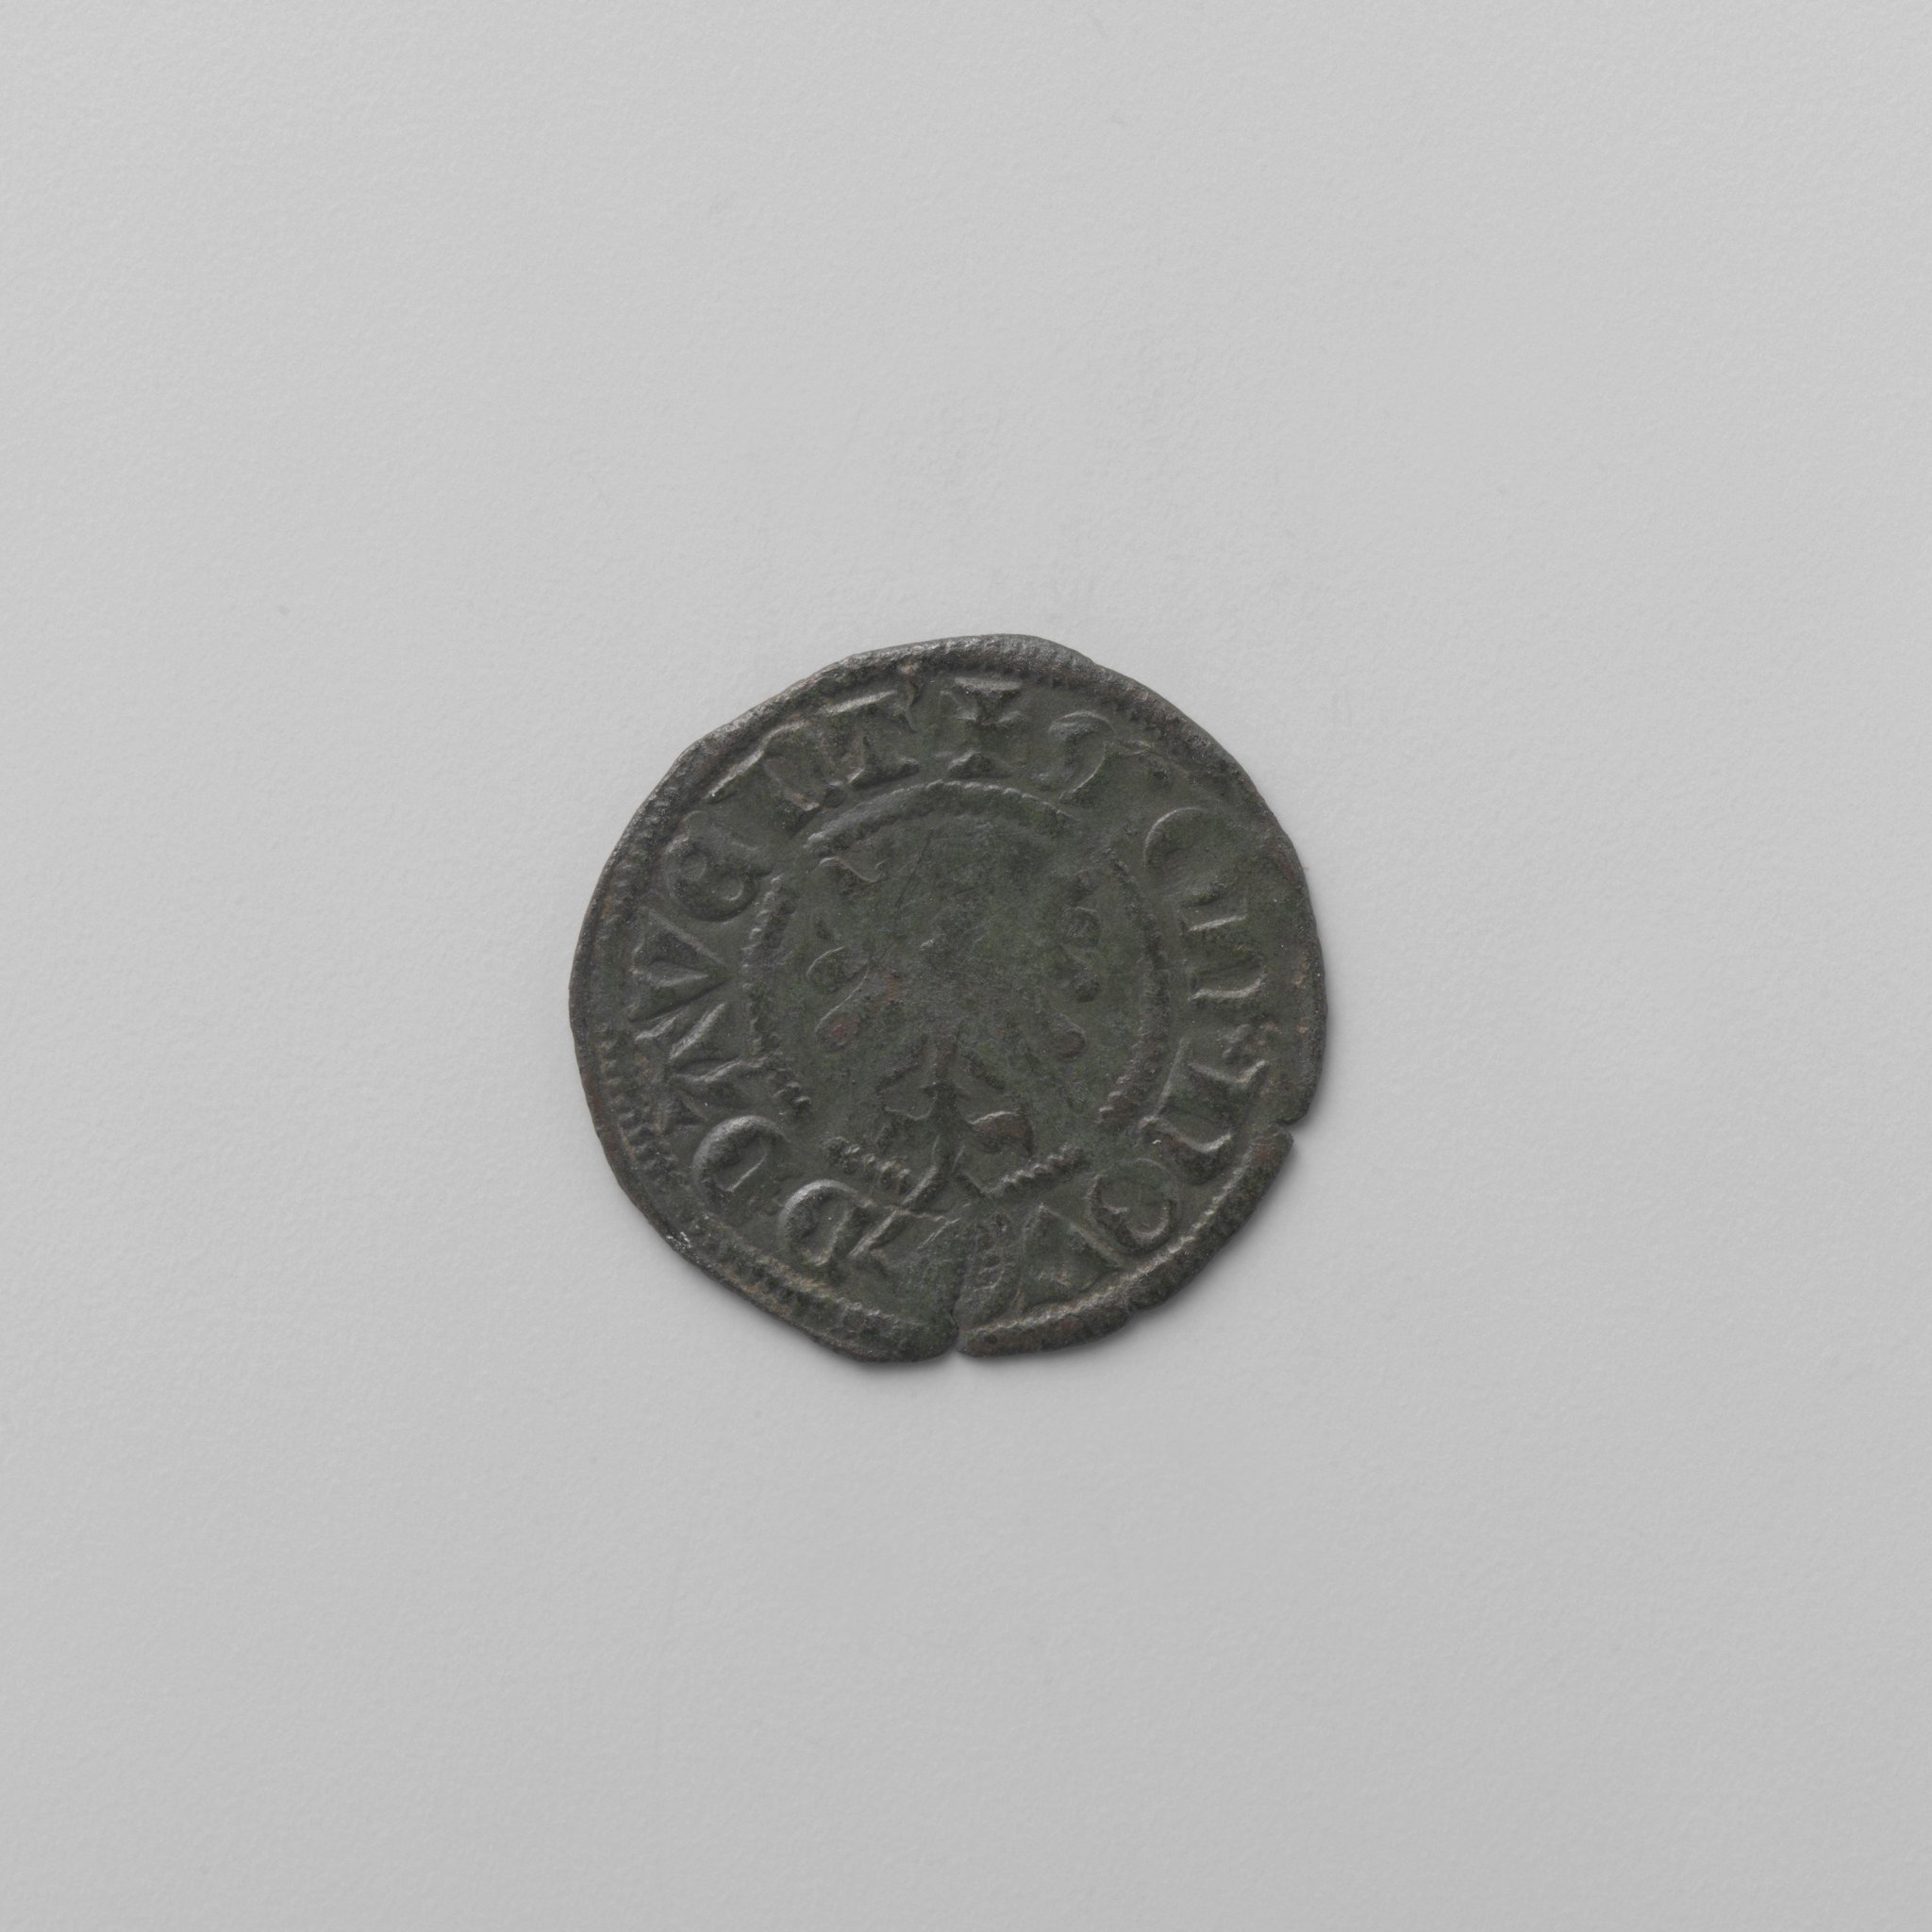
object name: coin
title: Plak van Deventer, 1523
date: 1523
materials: silver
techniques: striking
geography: deventer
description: Zilveren munt. Voorzijde: enkelkoppige adelaar met onder de poten schuin geplaatst wapenschild van Oversticht. Keerzijde: lang gevoet kruis. Jaartal in omschrift.